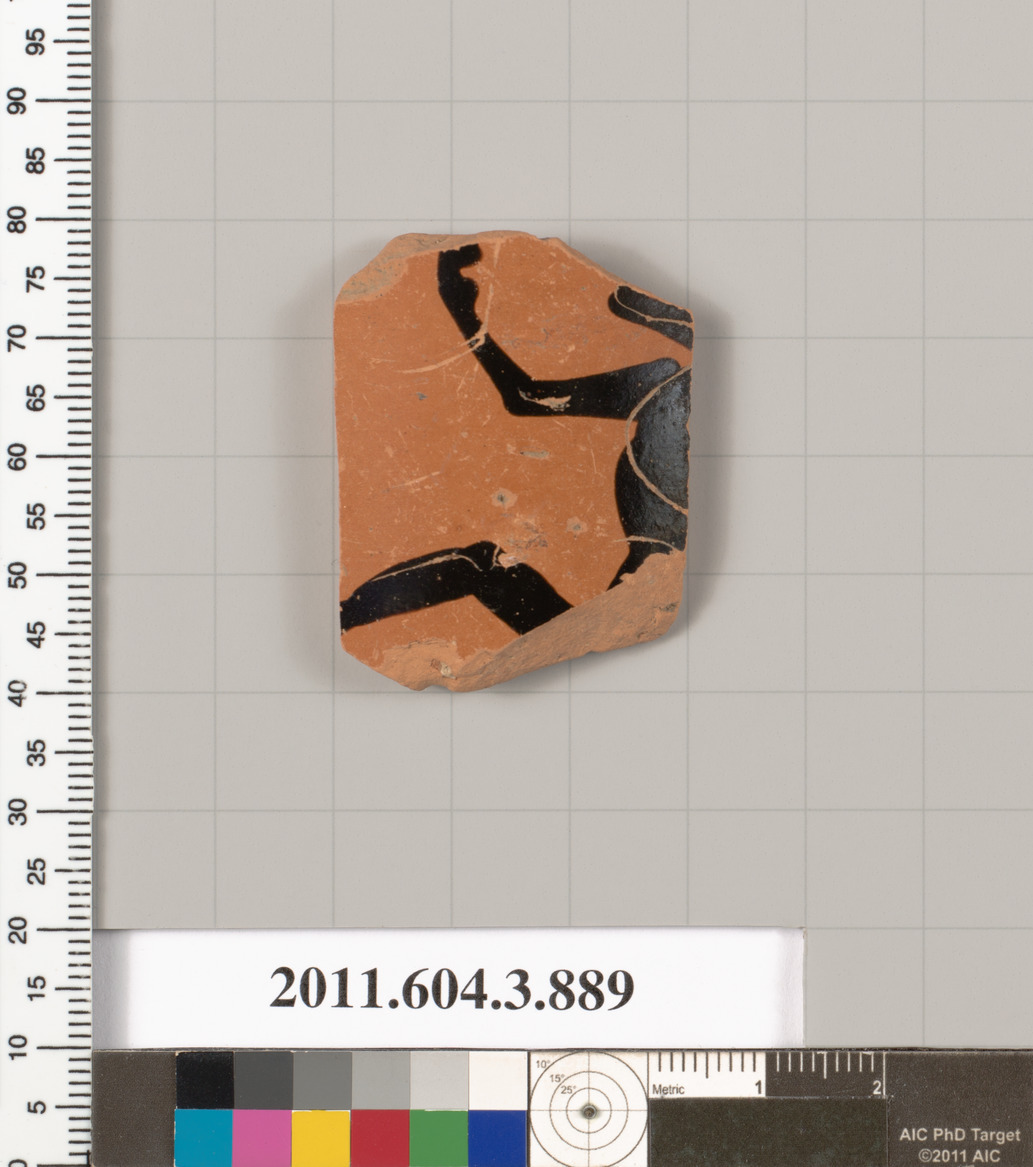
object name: lekythos fragment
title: Terracotta fragment of a lekythos (oil flask)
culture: greek, attic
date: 500-468 BCE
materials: terracotta